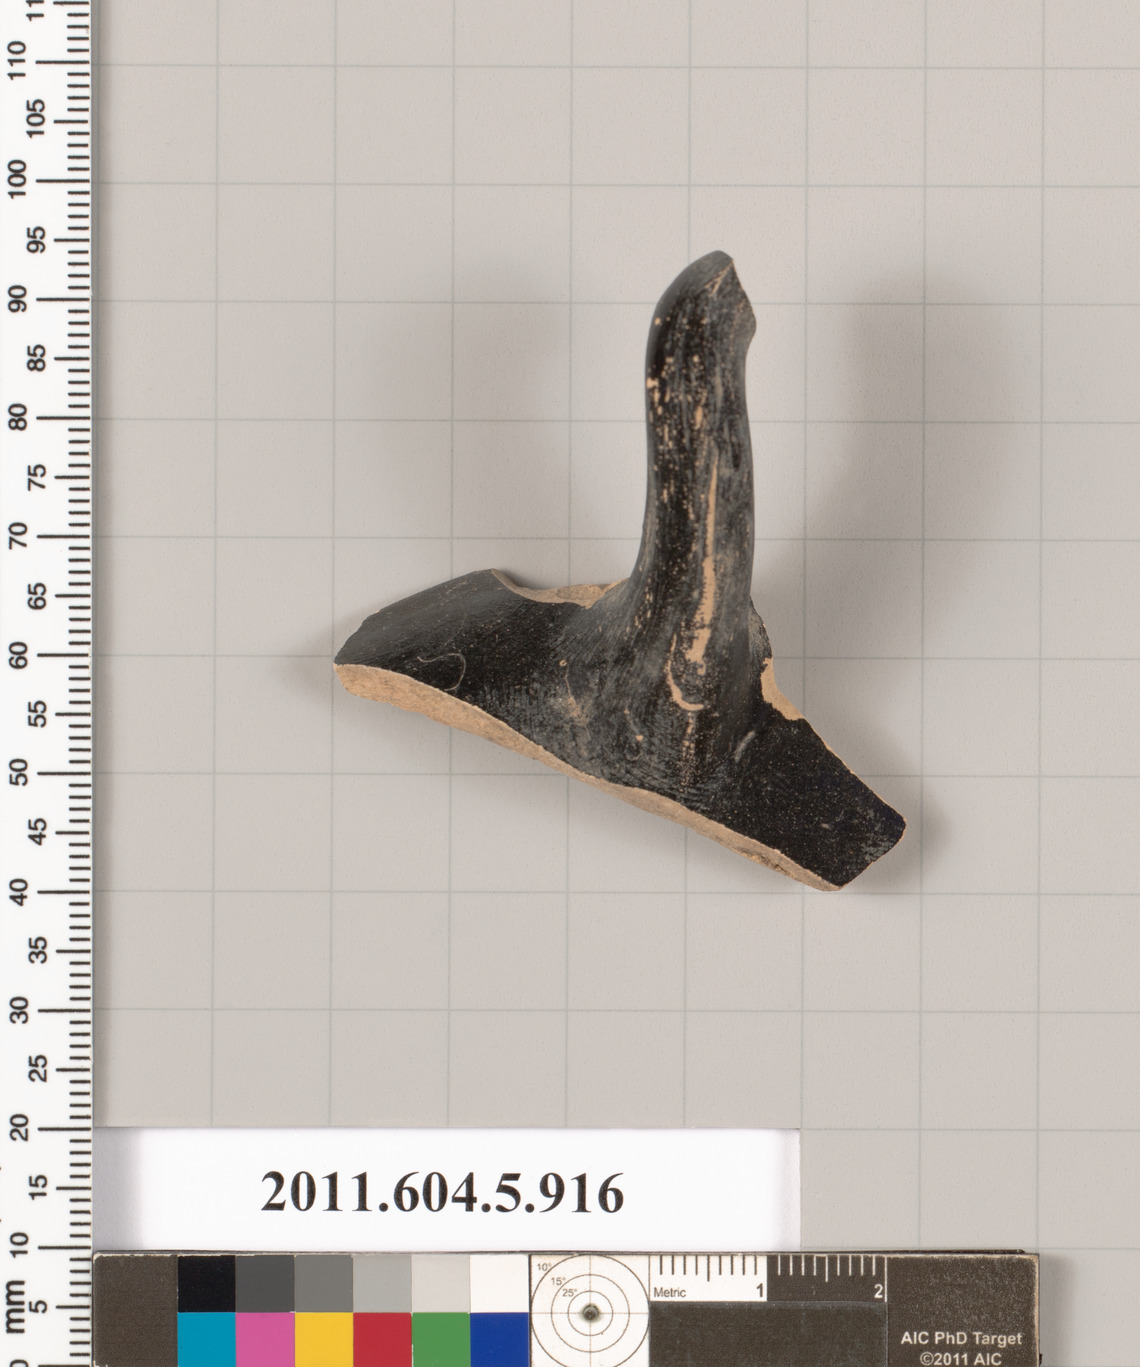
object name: kylix fragment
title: Terracotta fragment of a kylix (drinking cup)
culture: greek, attic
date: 500-401 BCE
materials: terracotta